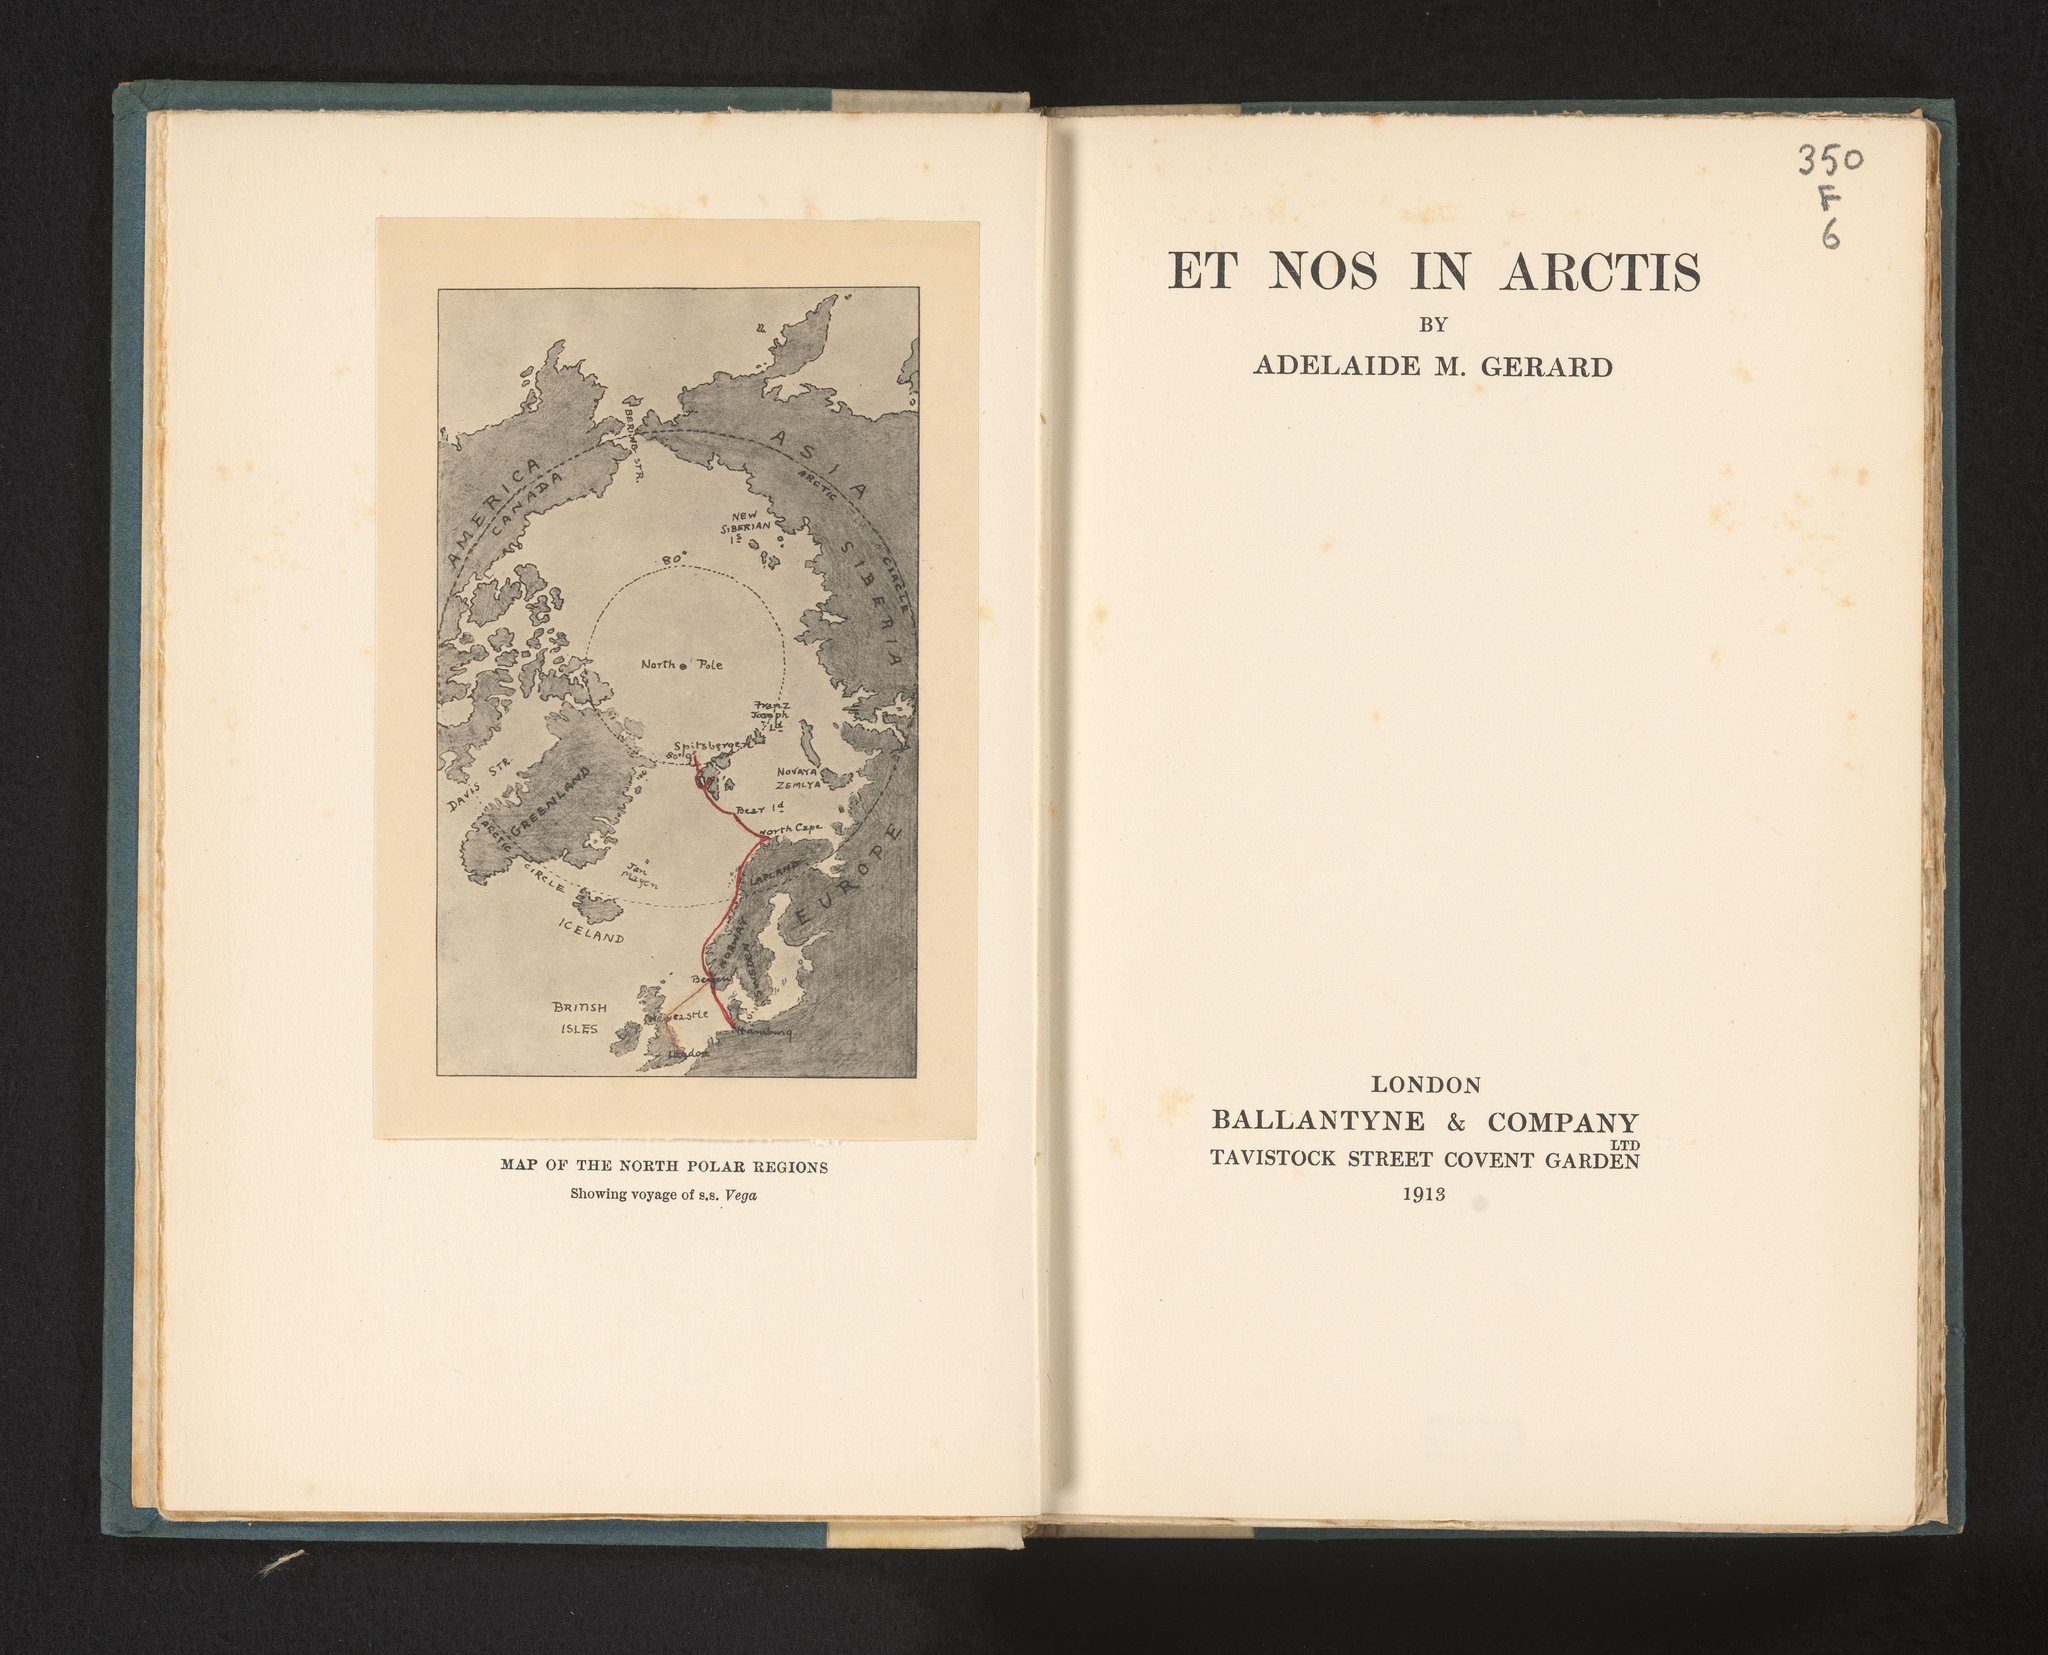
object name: book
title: Et nos in arctis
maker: adelaide m gerard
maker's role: schrijver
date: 1913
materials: paper, cardboard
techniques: gelatin silver print, letterpress printing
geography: london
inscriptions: inscription: ‘To/ Charles F. de Lanoy Meyer -/ with best wishes from A. M. Gerard./ [...] 1913.’